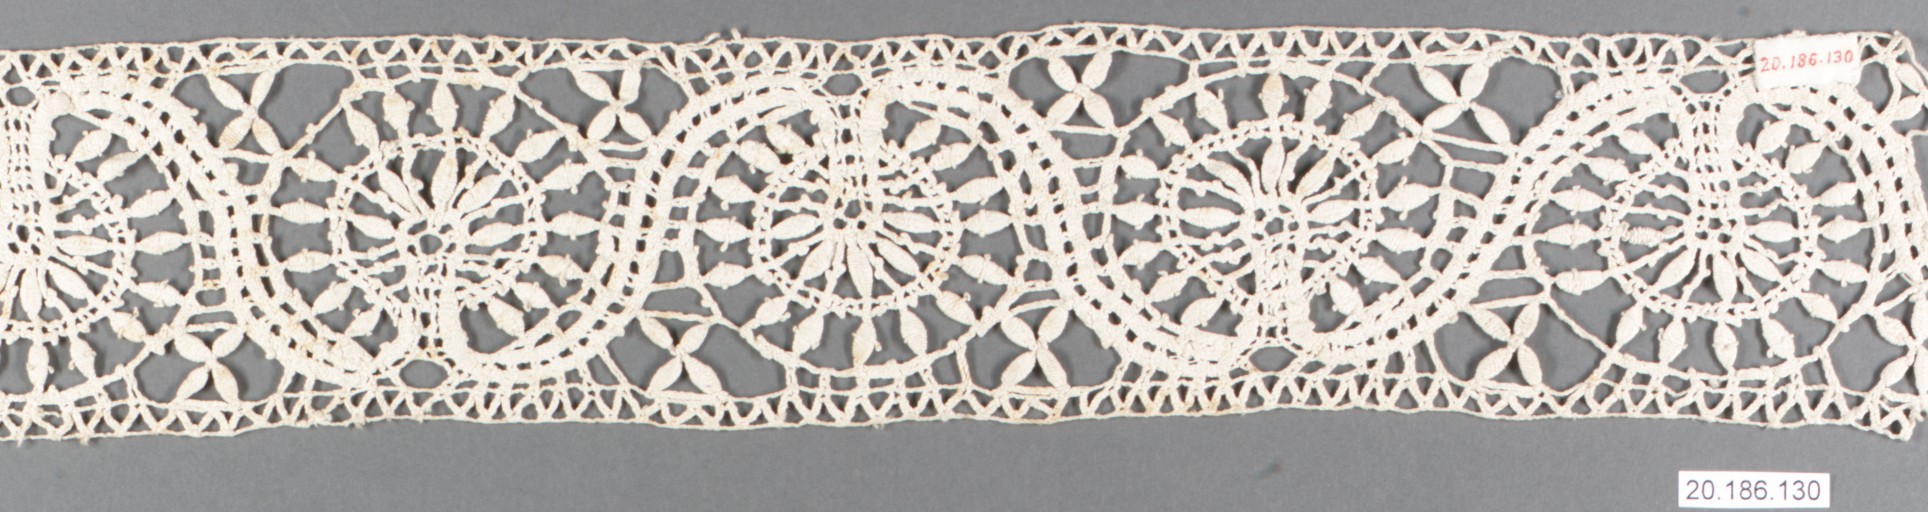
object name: insertion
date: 1601-1700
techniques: lace